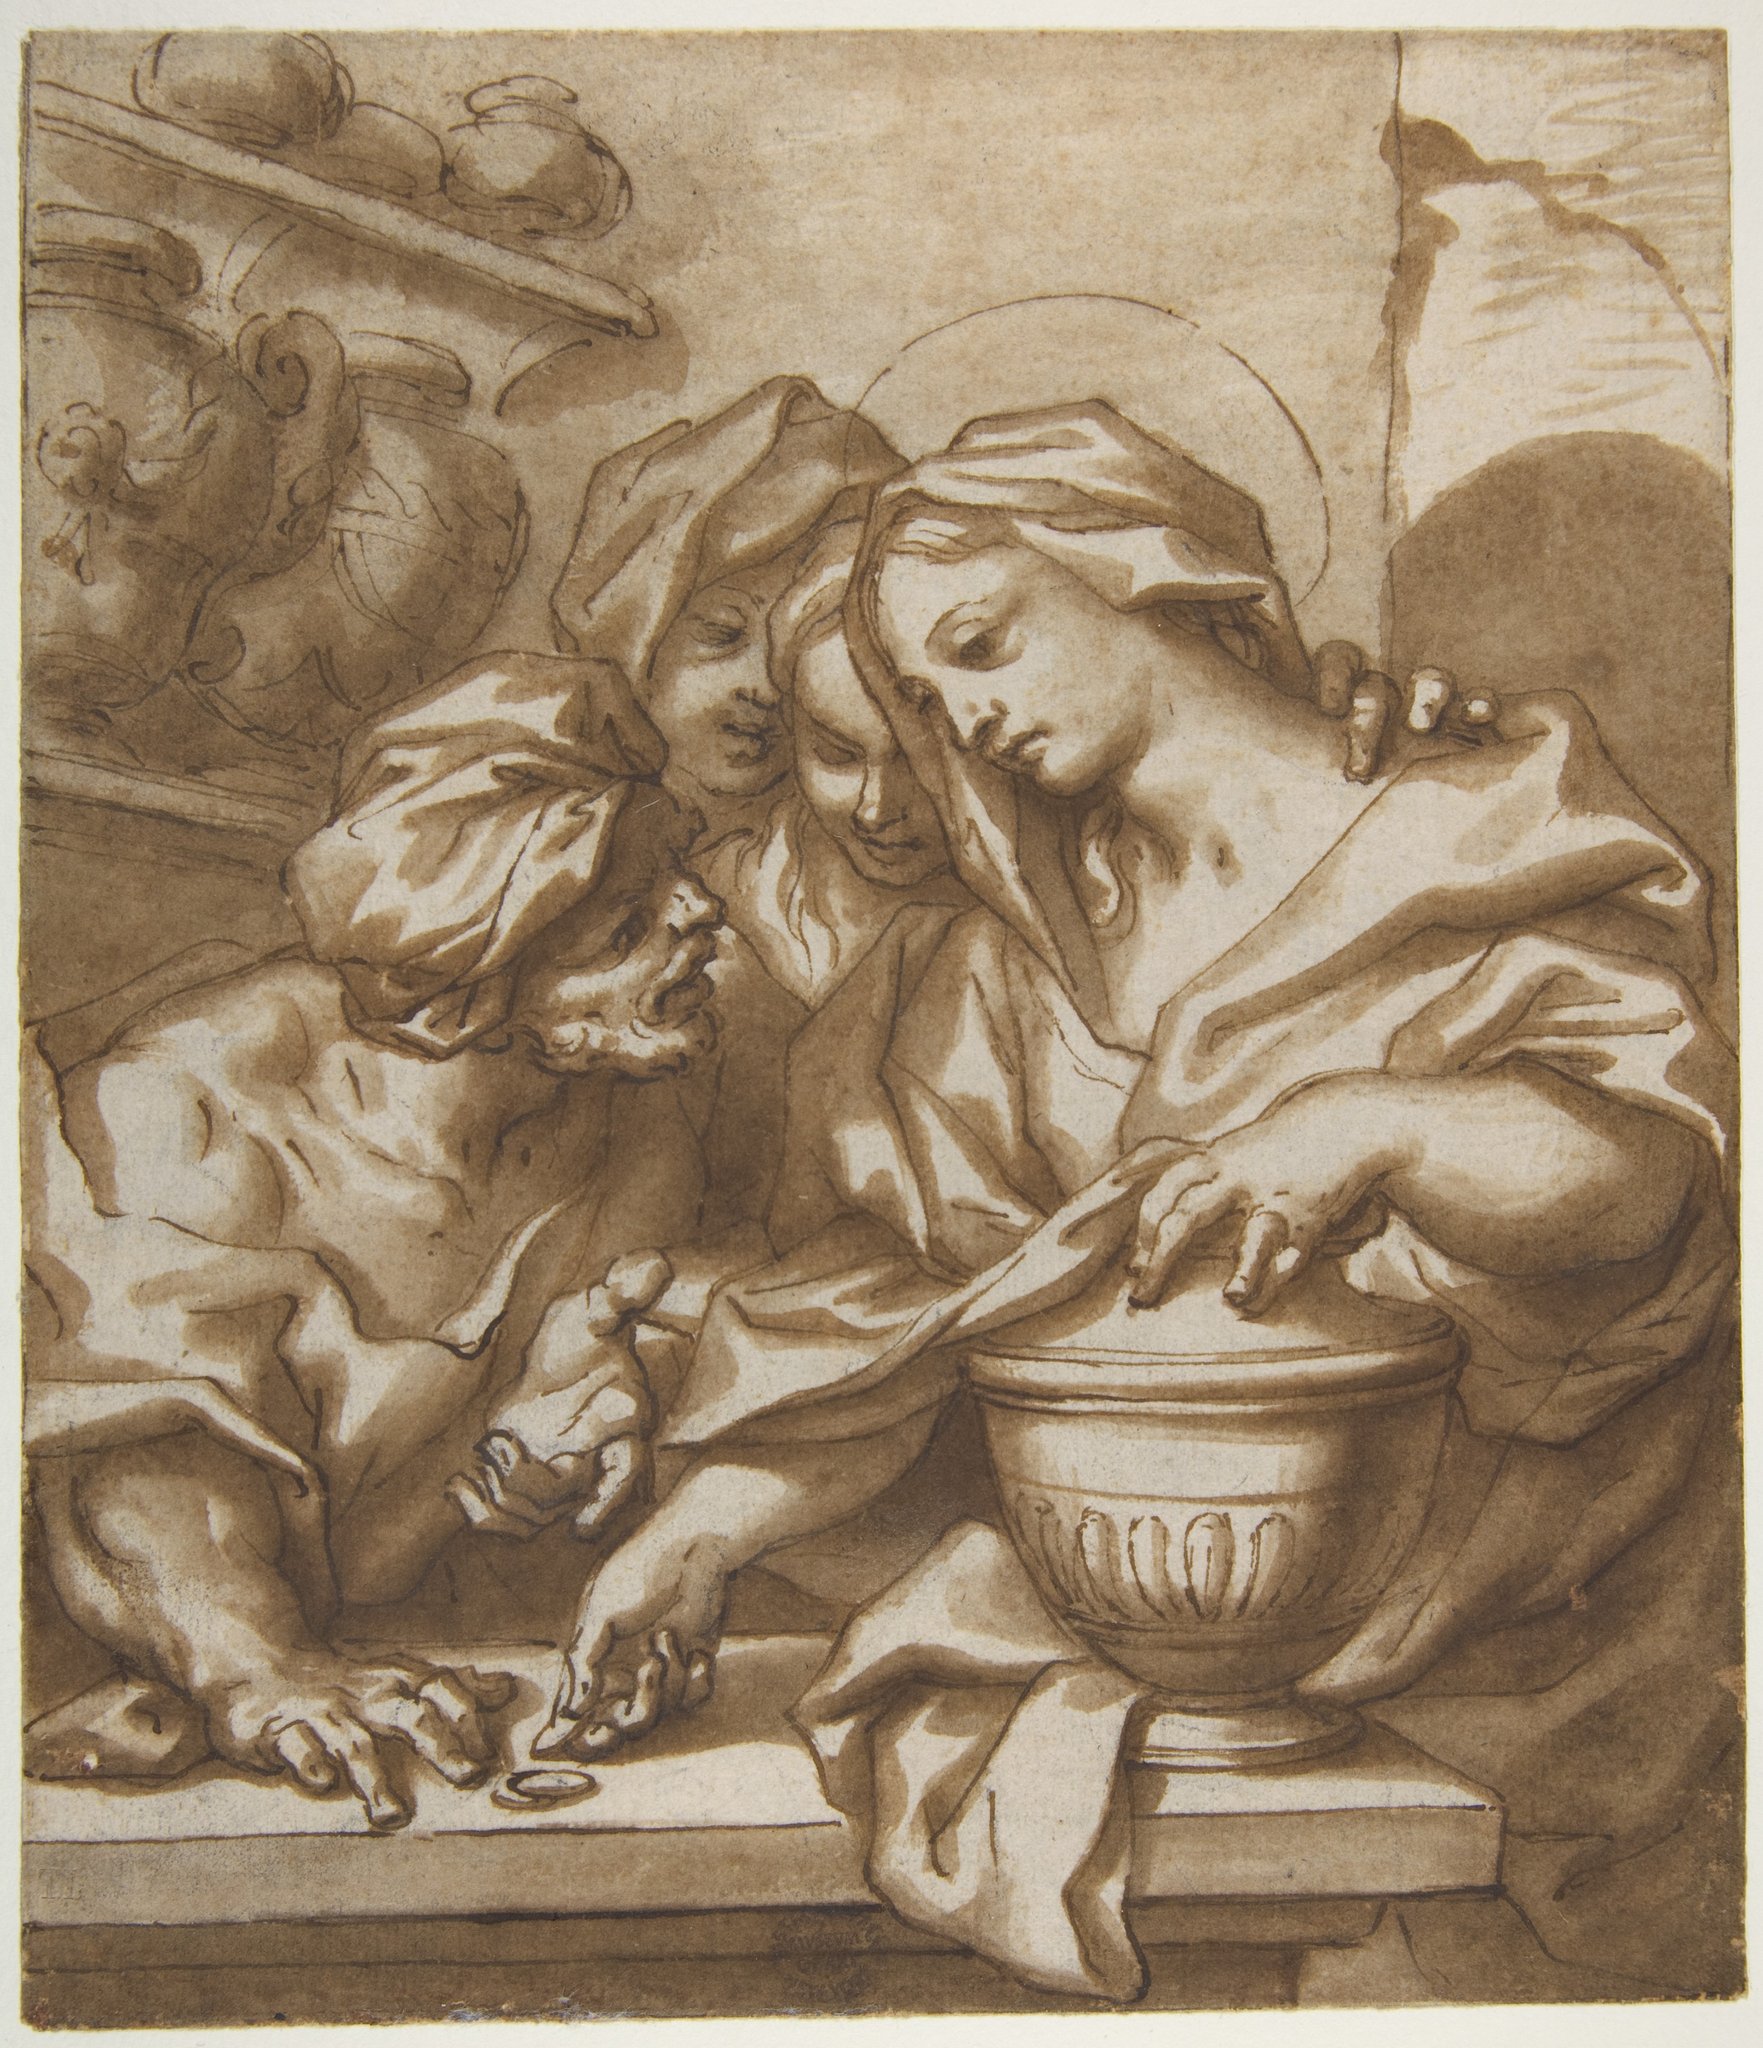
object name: drawing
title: Mary Magdalen Buying Ointment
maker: paolo gerolamo piola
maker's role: artist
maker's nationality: italian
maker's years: 1666-1724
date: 1666-1724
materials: ink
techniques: brush, pen, wash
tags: men,women,mary magdalene,coins